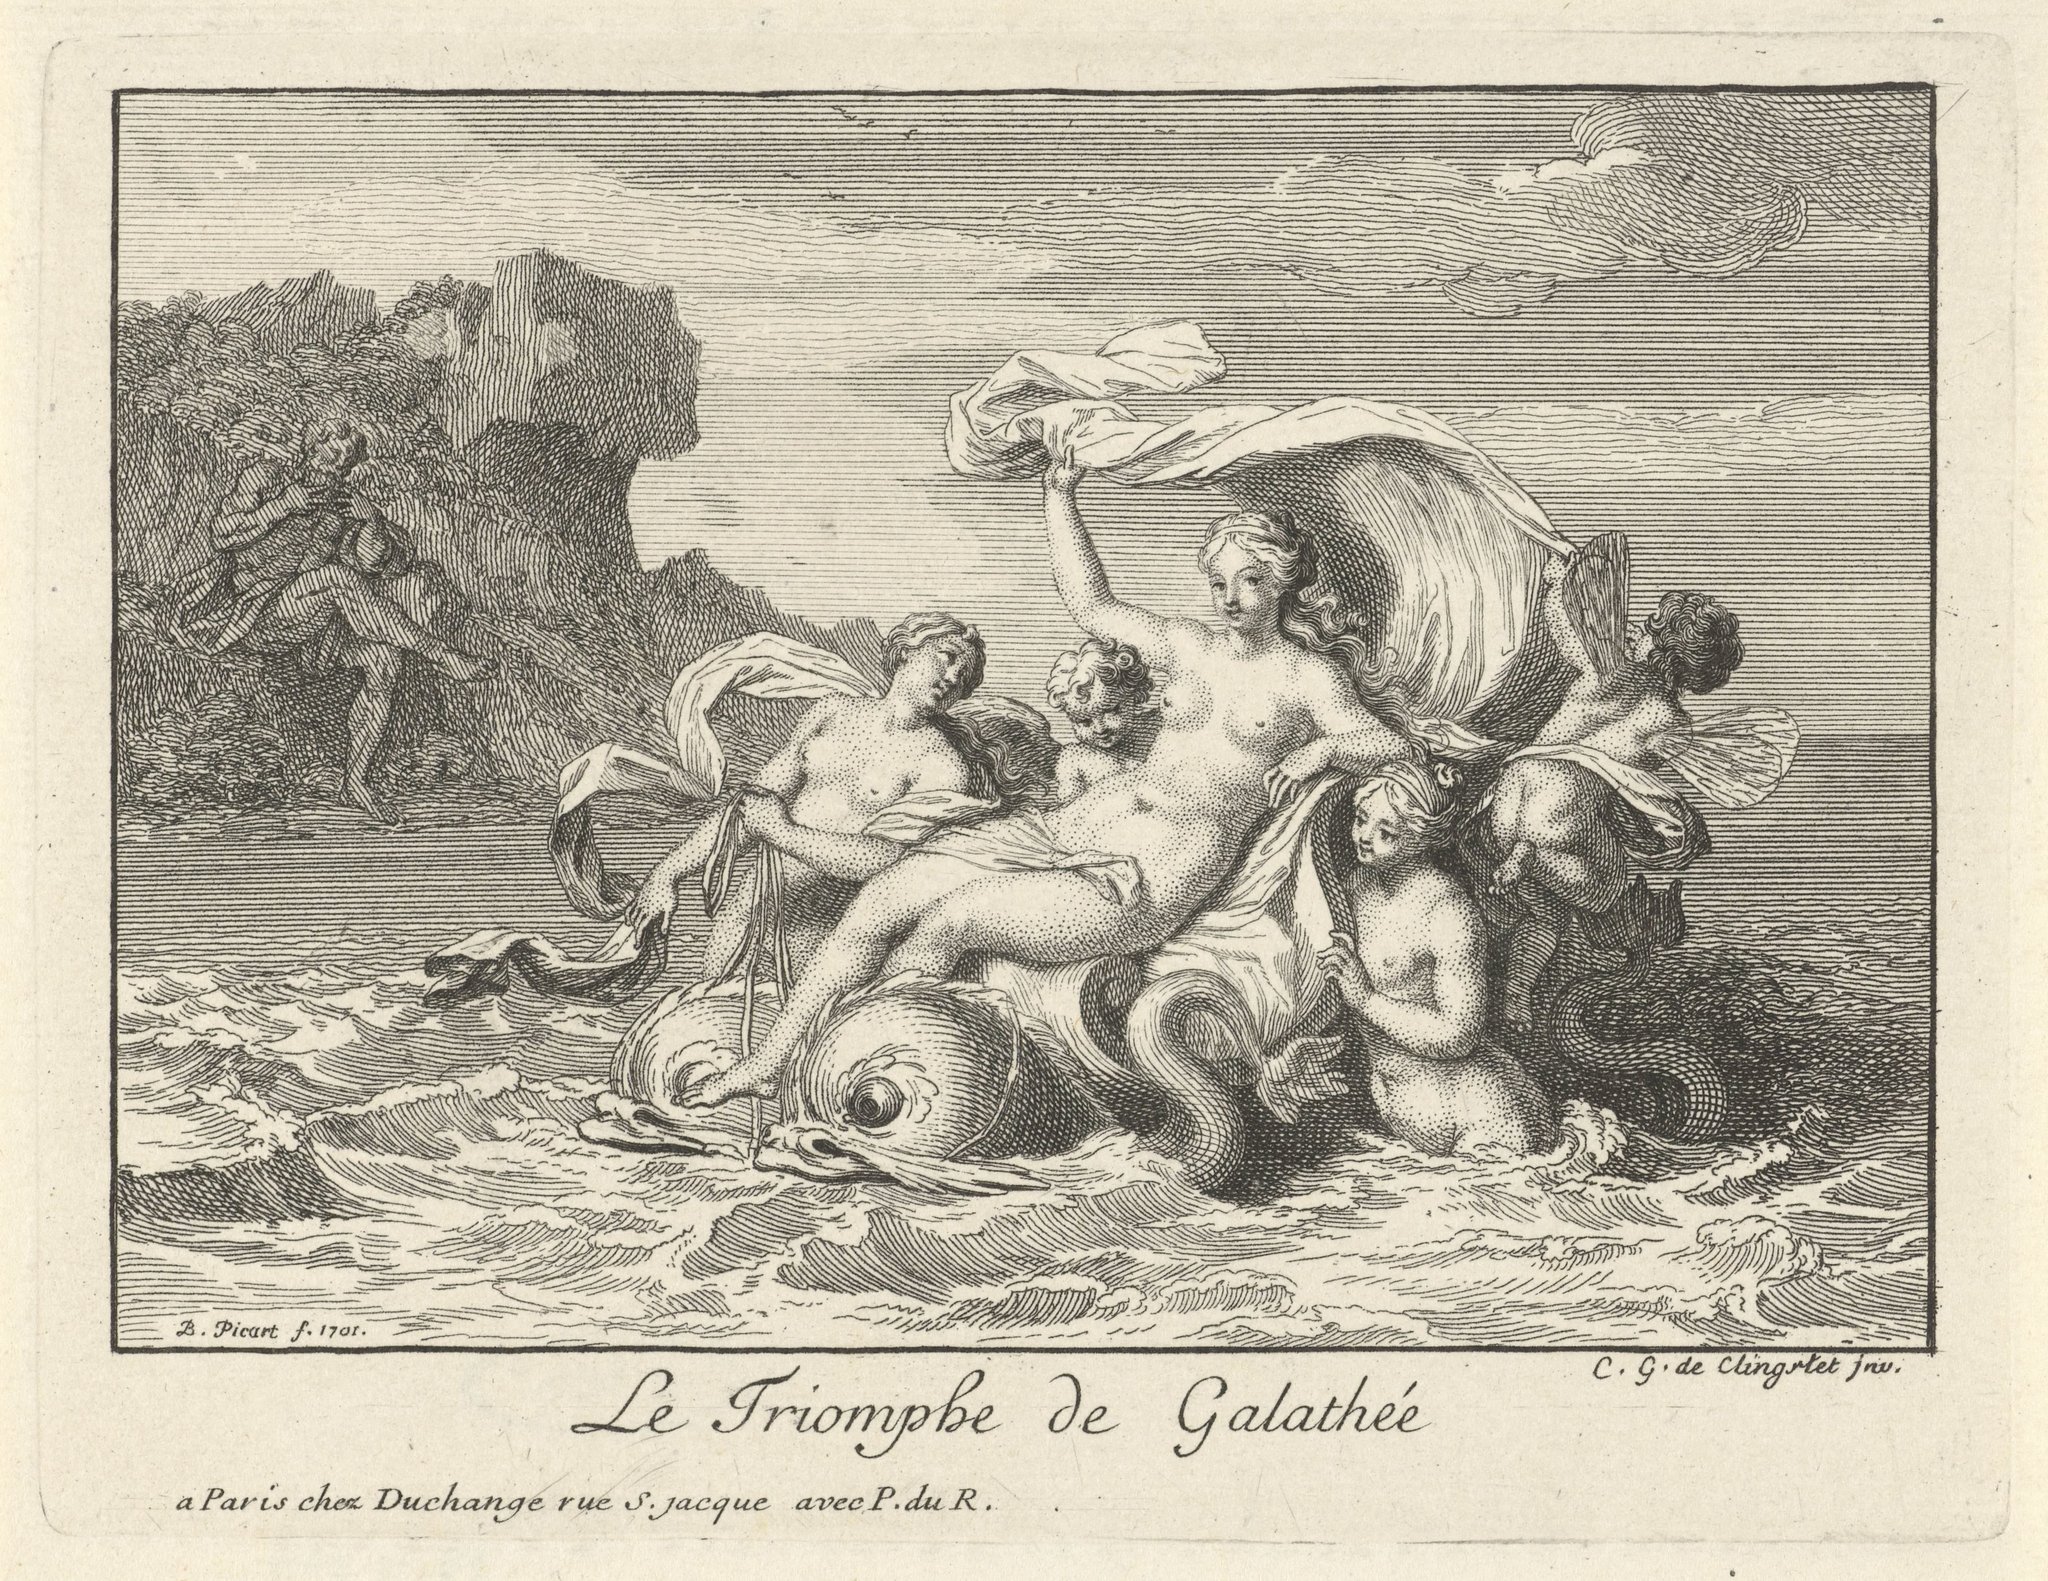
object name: print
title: Triomf van Galatea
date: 1701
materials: paper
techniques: engraving, etching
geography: paris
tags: triumph of galatea, polyphemus playing the syrinx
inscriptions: collector's mark: Lugt 2228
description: De zeenimf Galatea rust achterover op een wagen, voortgetrokken door vissen. Ze wordt omringd door nimfen en putti. In de lucht zweeft Polyphemus die op zijn panfluit een liefdeslied speelt voor Galatea.